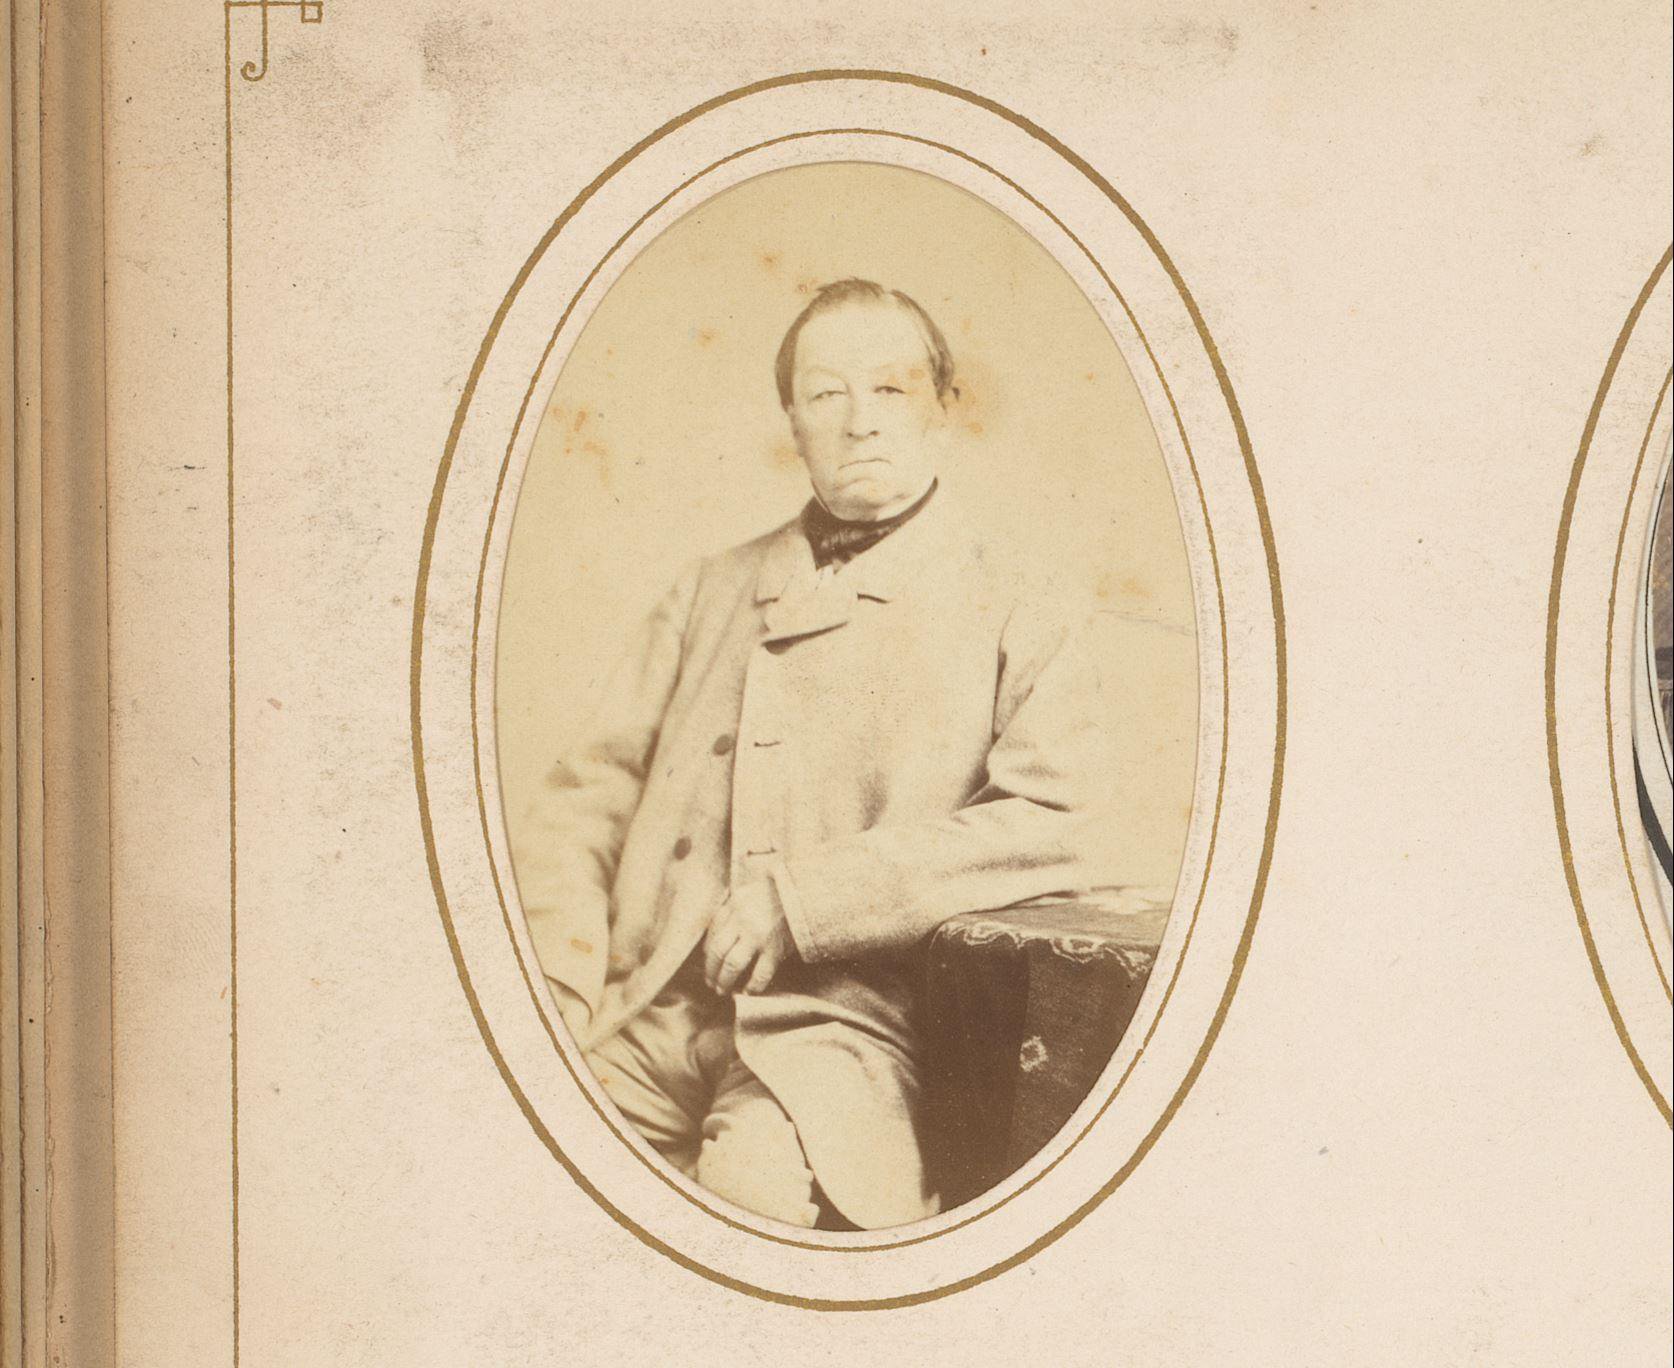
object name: photograph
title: Portret van een man, zittend aan een tafel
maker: hector de saedeler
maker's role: fotograaf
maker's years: 1826-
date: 1861-1868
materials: cardboard, photographic support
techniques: albumen print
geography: brussels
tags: sitting figure, historical persons, table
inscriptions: inscription: ‘HECTOR de SAEDELER/ PHOTOGRAPHE/ Chausée de Haecht 30/ BRUXELLES/ On peut se procurer de ces/ portraits indéfiniment’